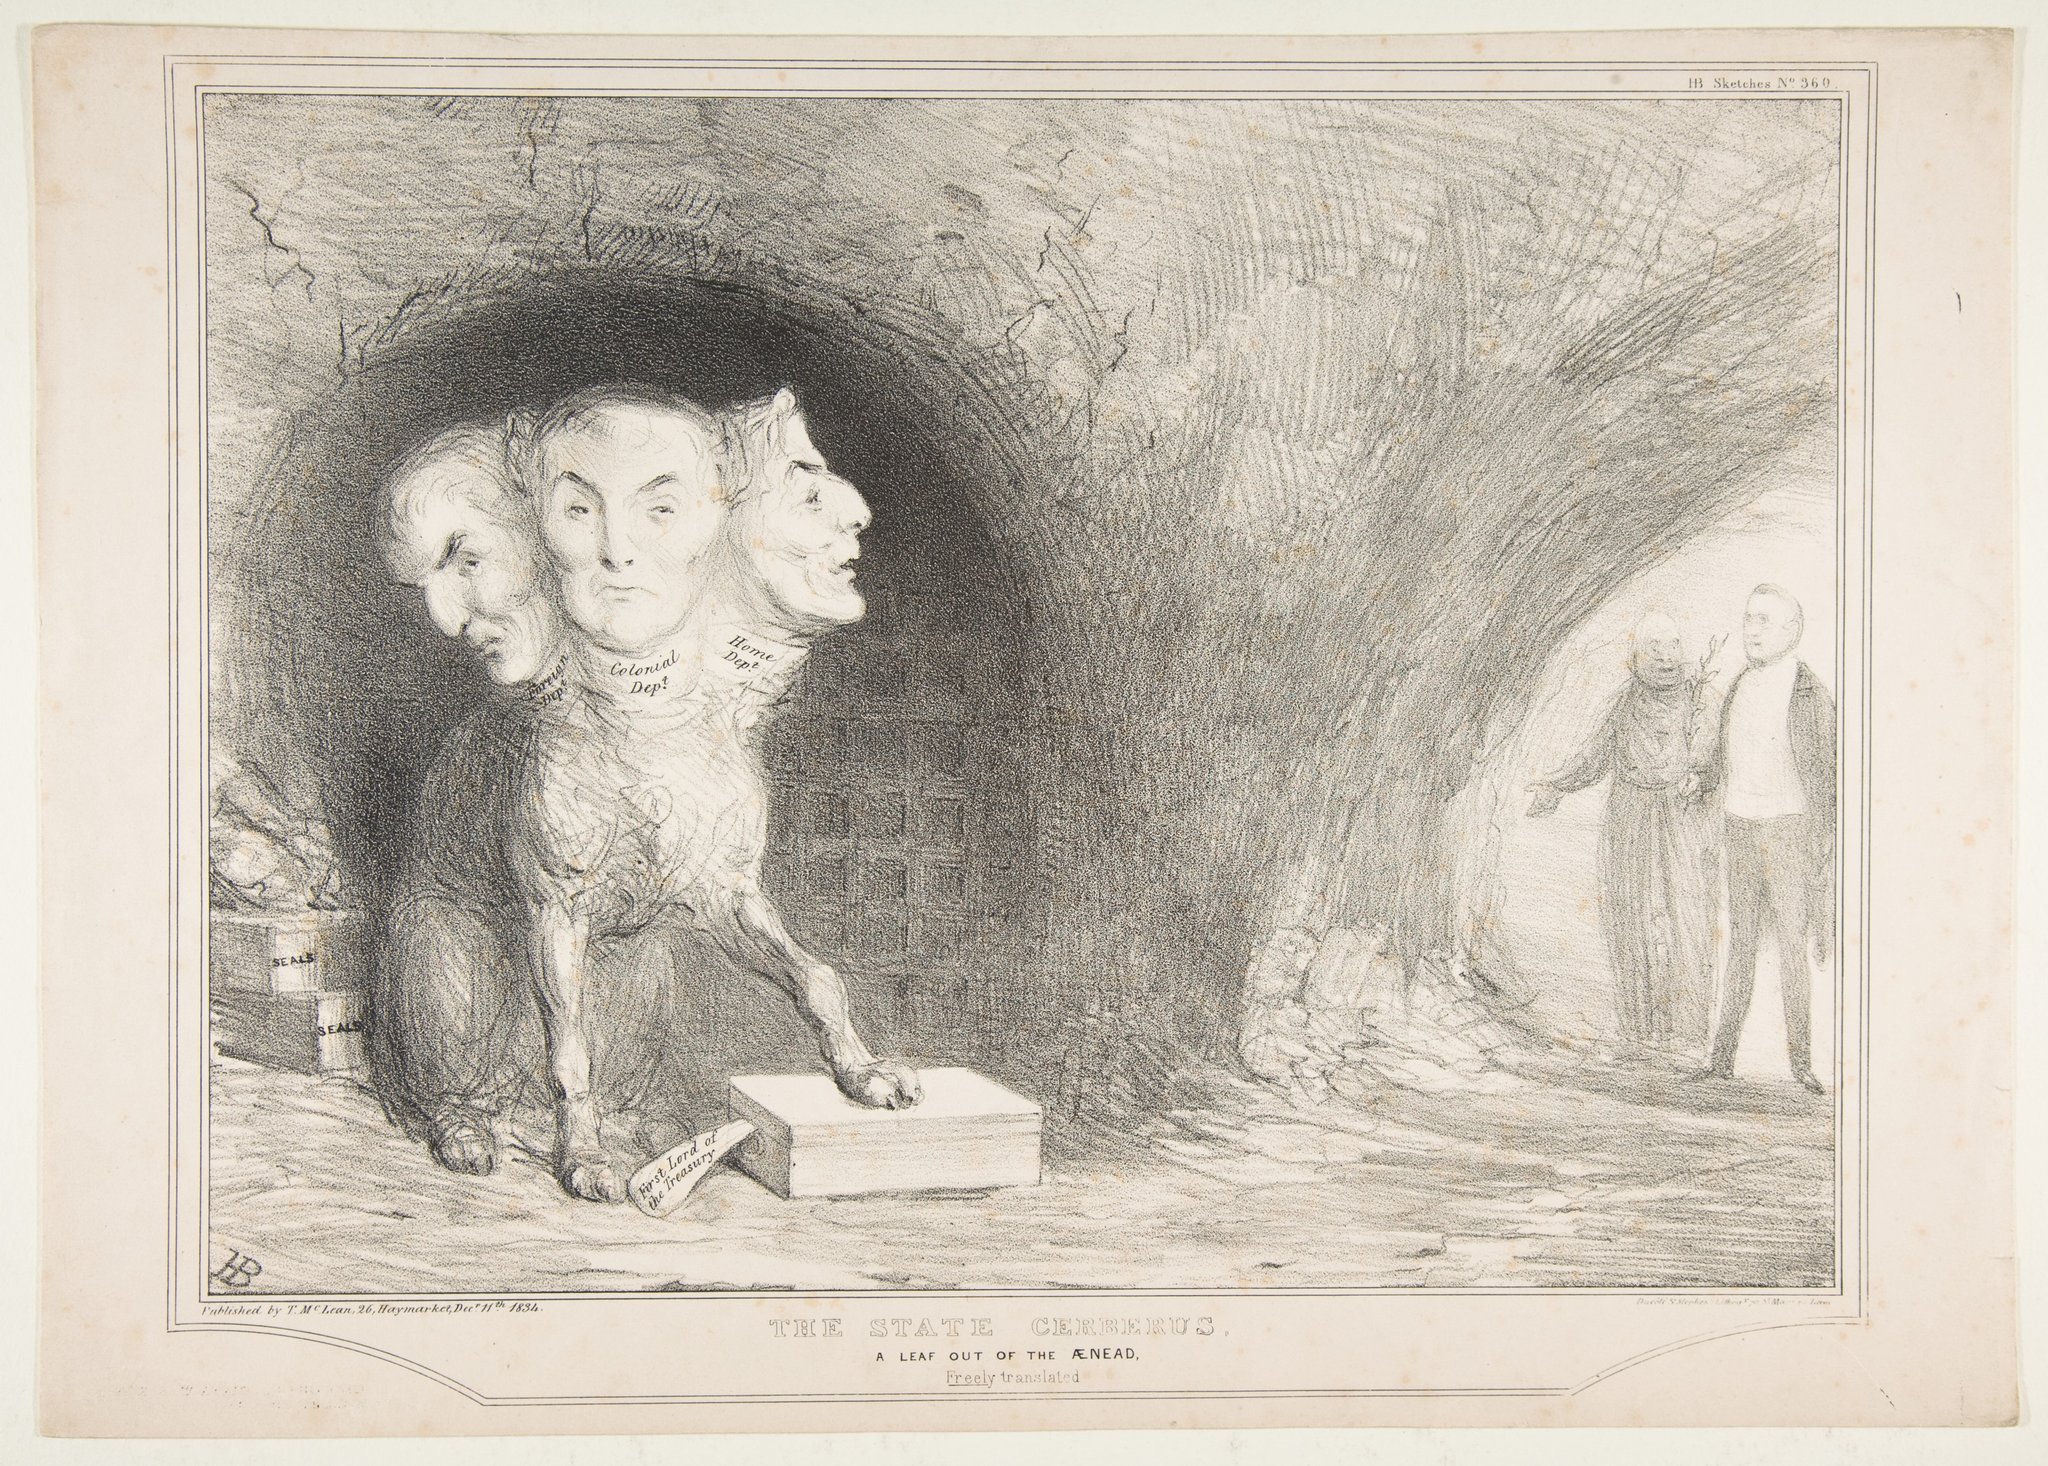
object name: print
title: The State Cerberus, A Leaf Out of the Ænead, Freely Translated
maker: john doyle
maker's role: artist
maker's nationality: irish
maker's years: 1797-1868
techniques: lithograph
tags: men,caricature,politics